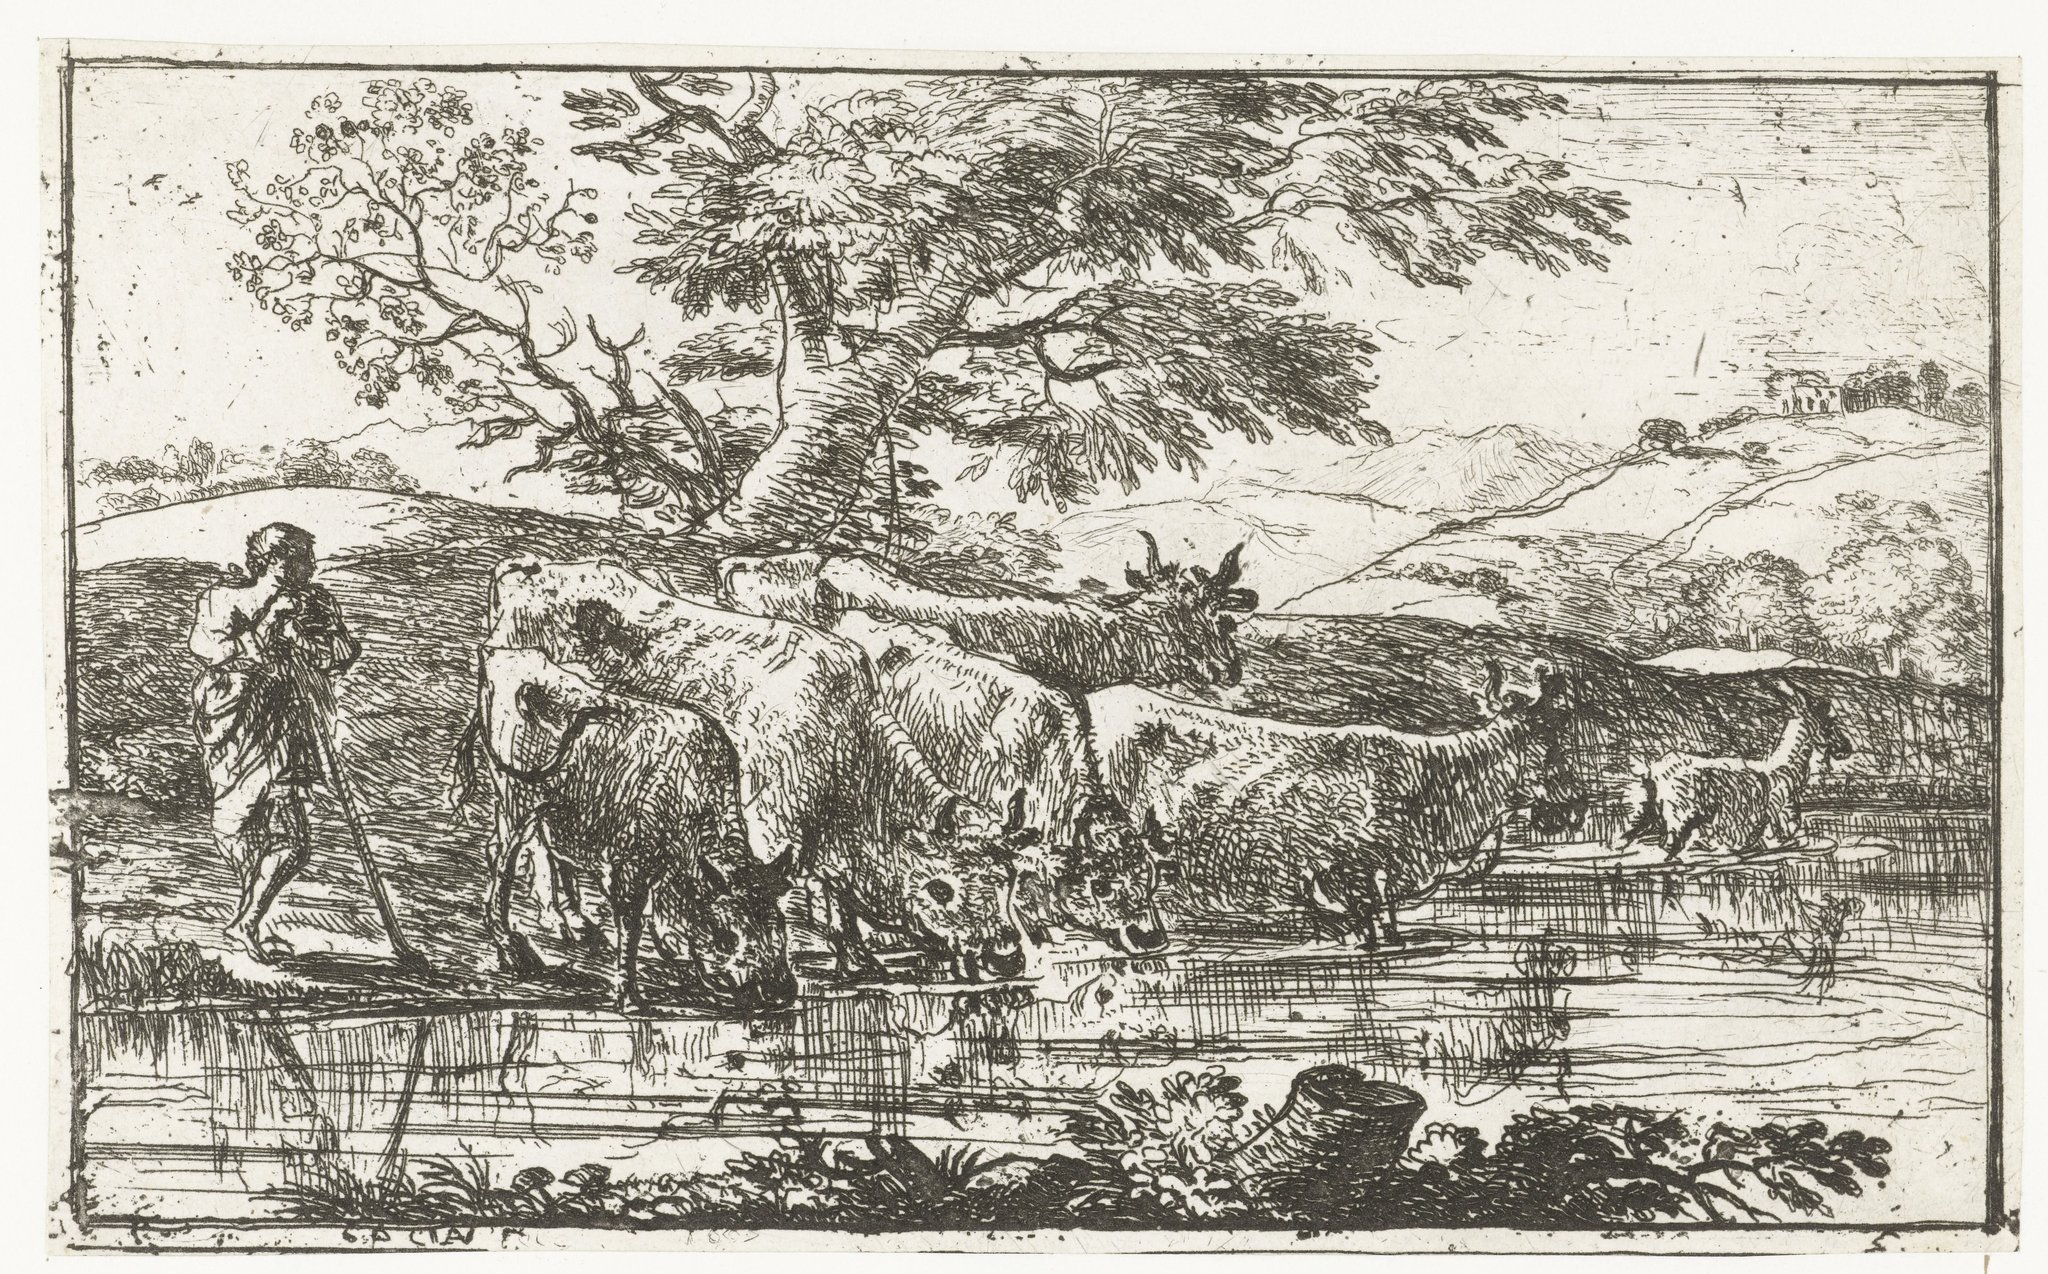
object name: print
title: Le Troupeau à l'abreuvoir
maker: claude lorrain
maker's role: draughtsman, print maker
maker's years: 1604-1682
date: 1635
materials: paper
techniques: etching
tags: herding, herdsman, herdswoman, shepherd, shepherdess, cowherd, etc., watering-place, spa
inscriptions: collector's mark: Lugt 2228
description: Een herder met een kudde koeien en een geit bij een waterplaats.